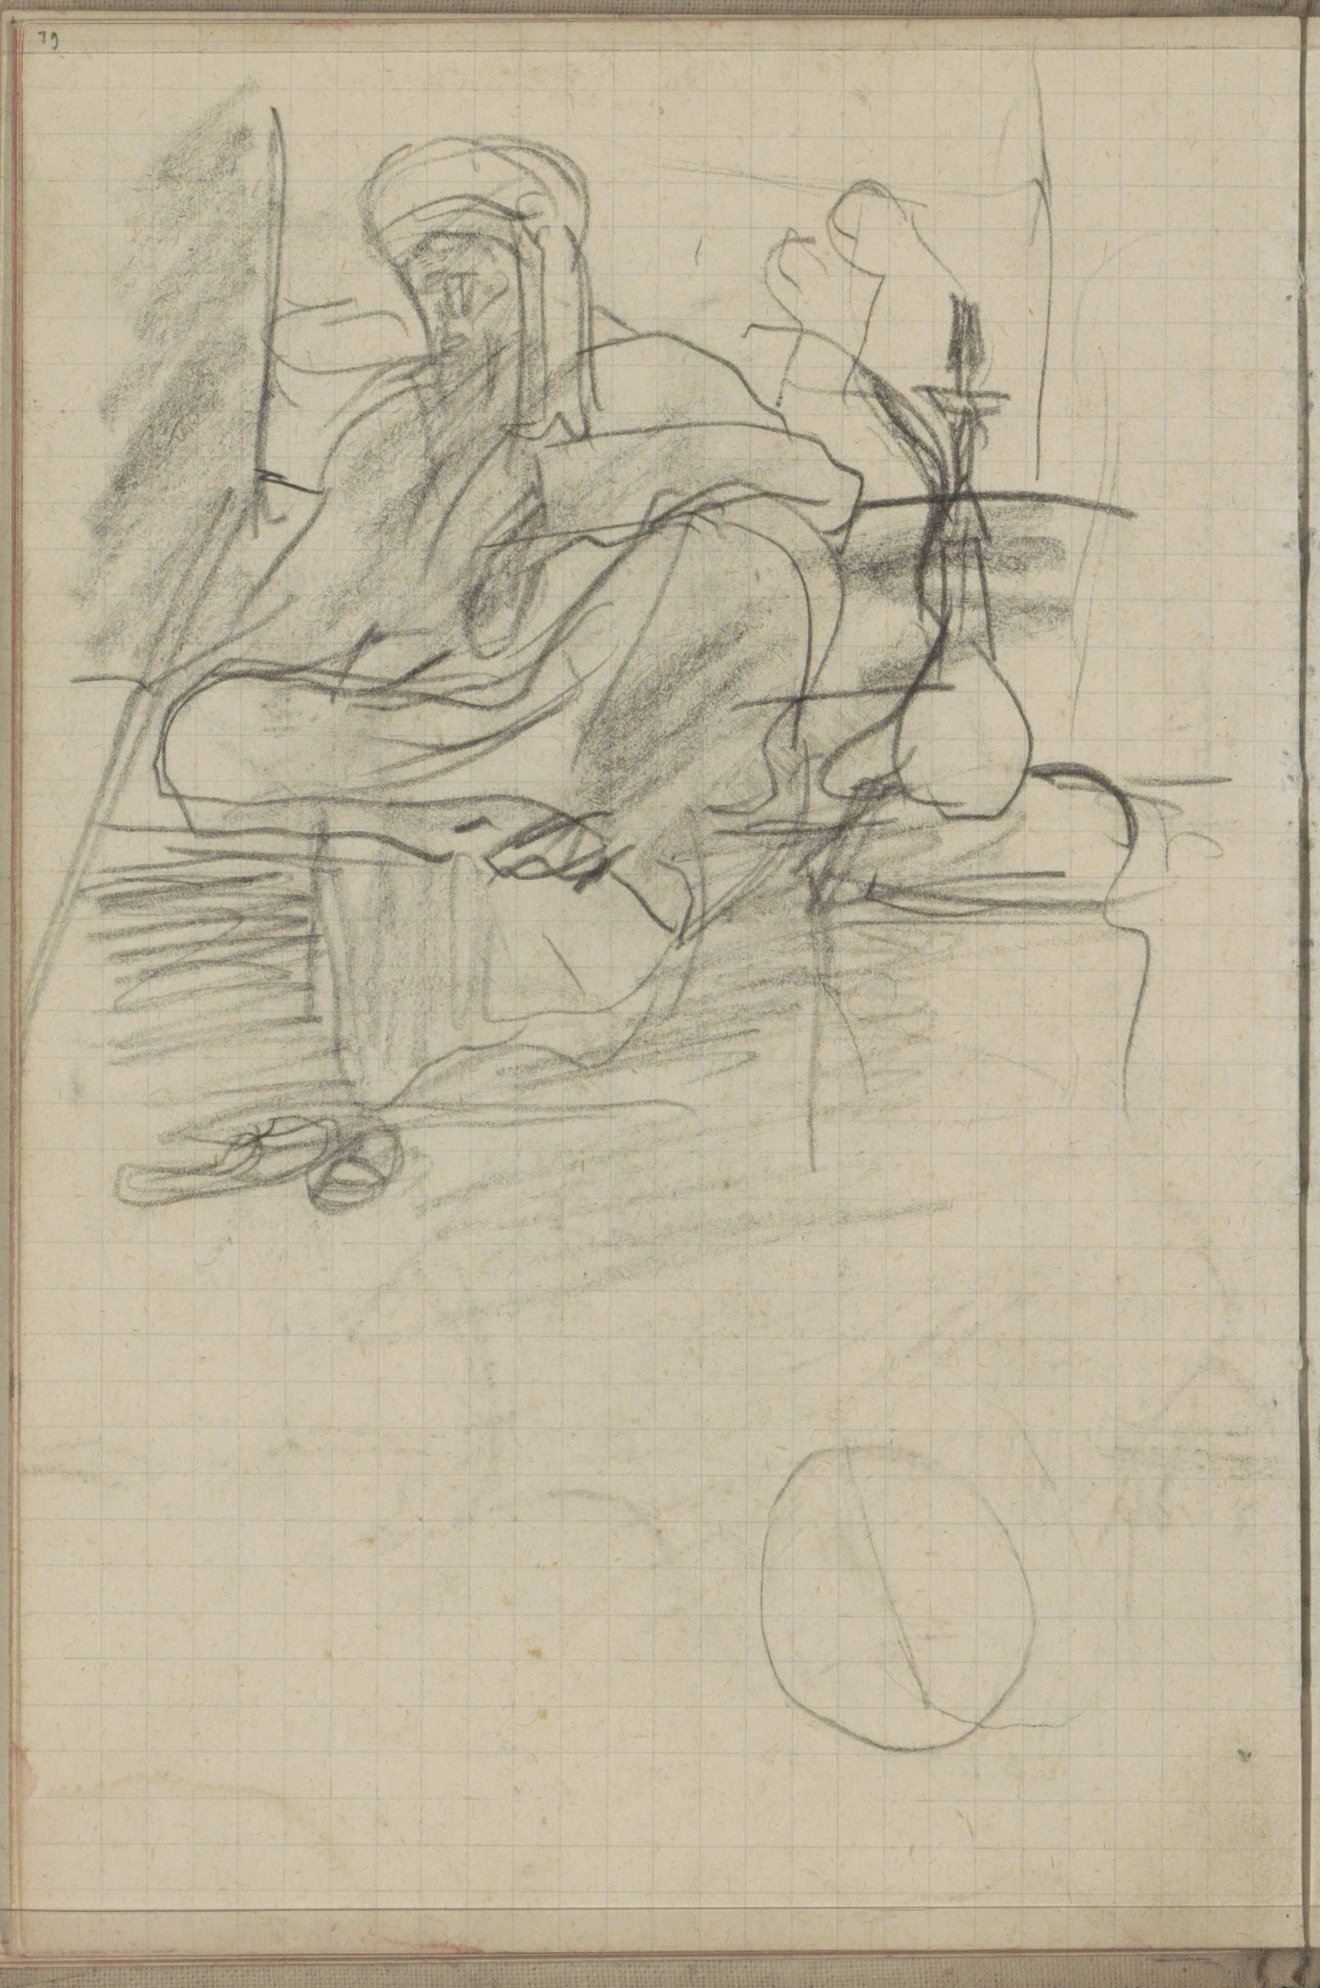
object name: sketchbook leaf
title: Zittende man met waterpijp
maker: marius bauer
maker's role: draughtsman, print maker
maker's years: 1867-1932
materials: chalk, paper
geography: istanbul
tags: water-pipe, hookah, narghile, asiatic races and peoples, sitting figure, adult man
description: In oosterse kleding en tulband. Pagina 79 uit een schetsboek met 51 bladen.